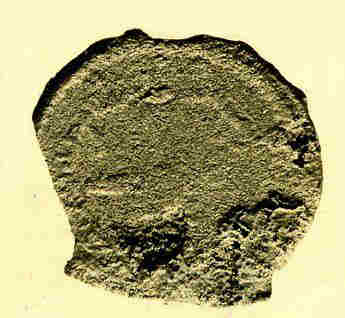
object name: coin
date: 776-785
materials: copper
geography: iran